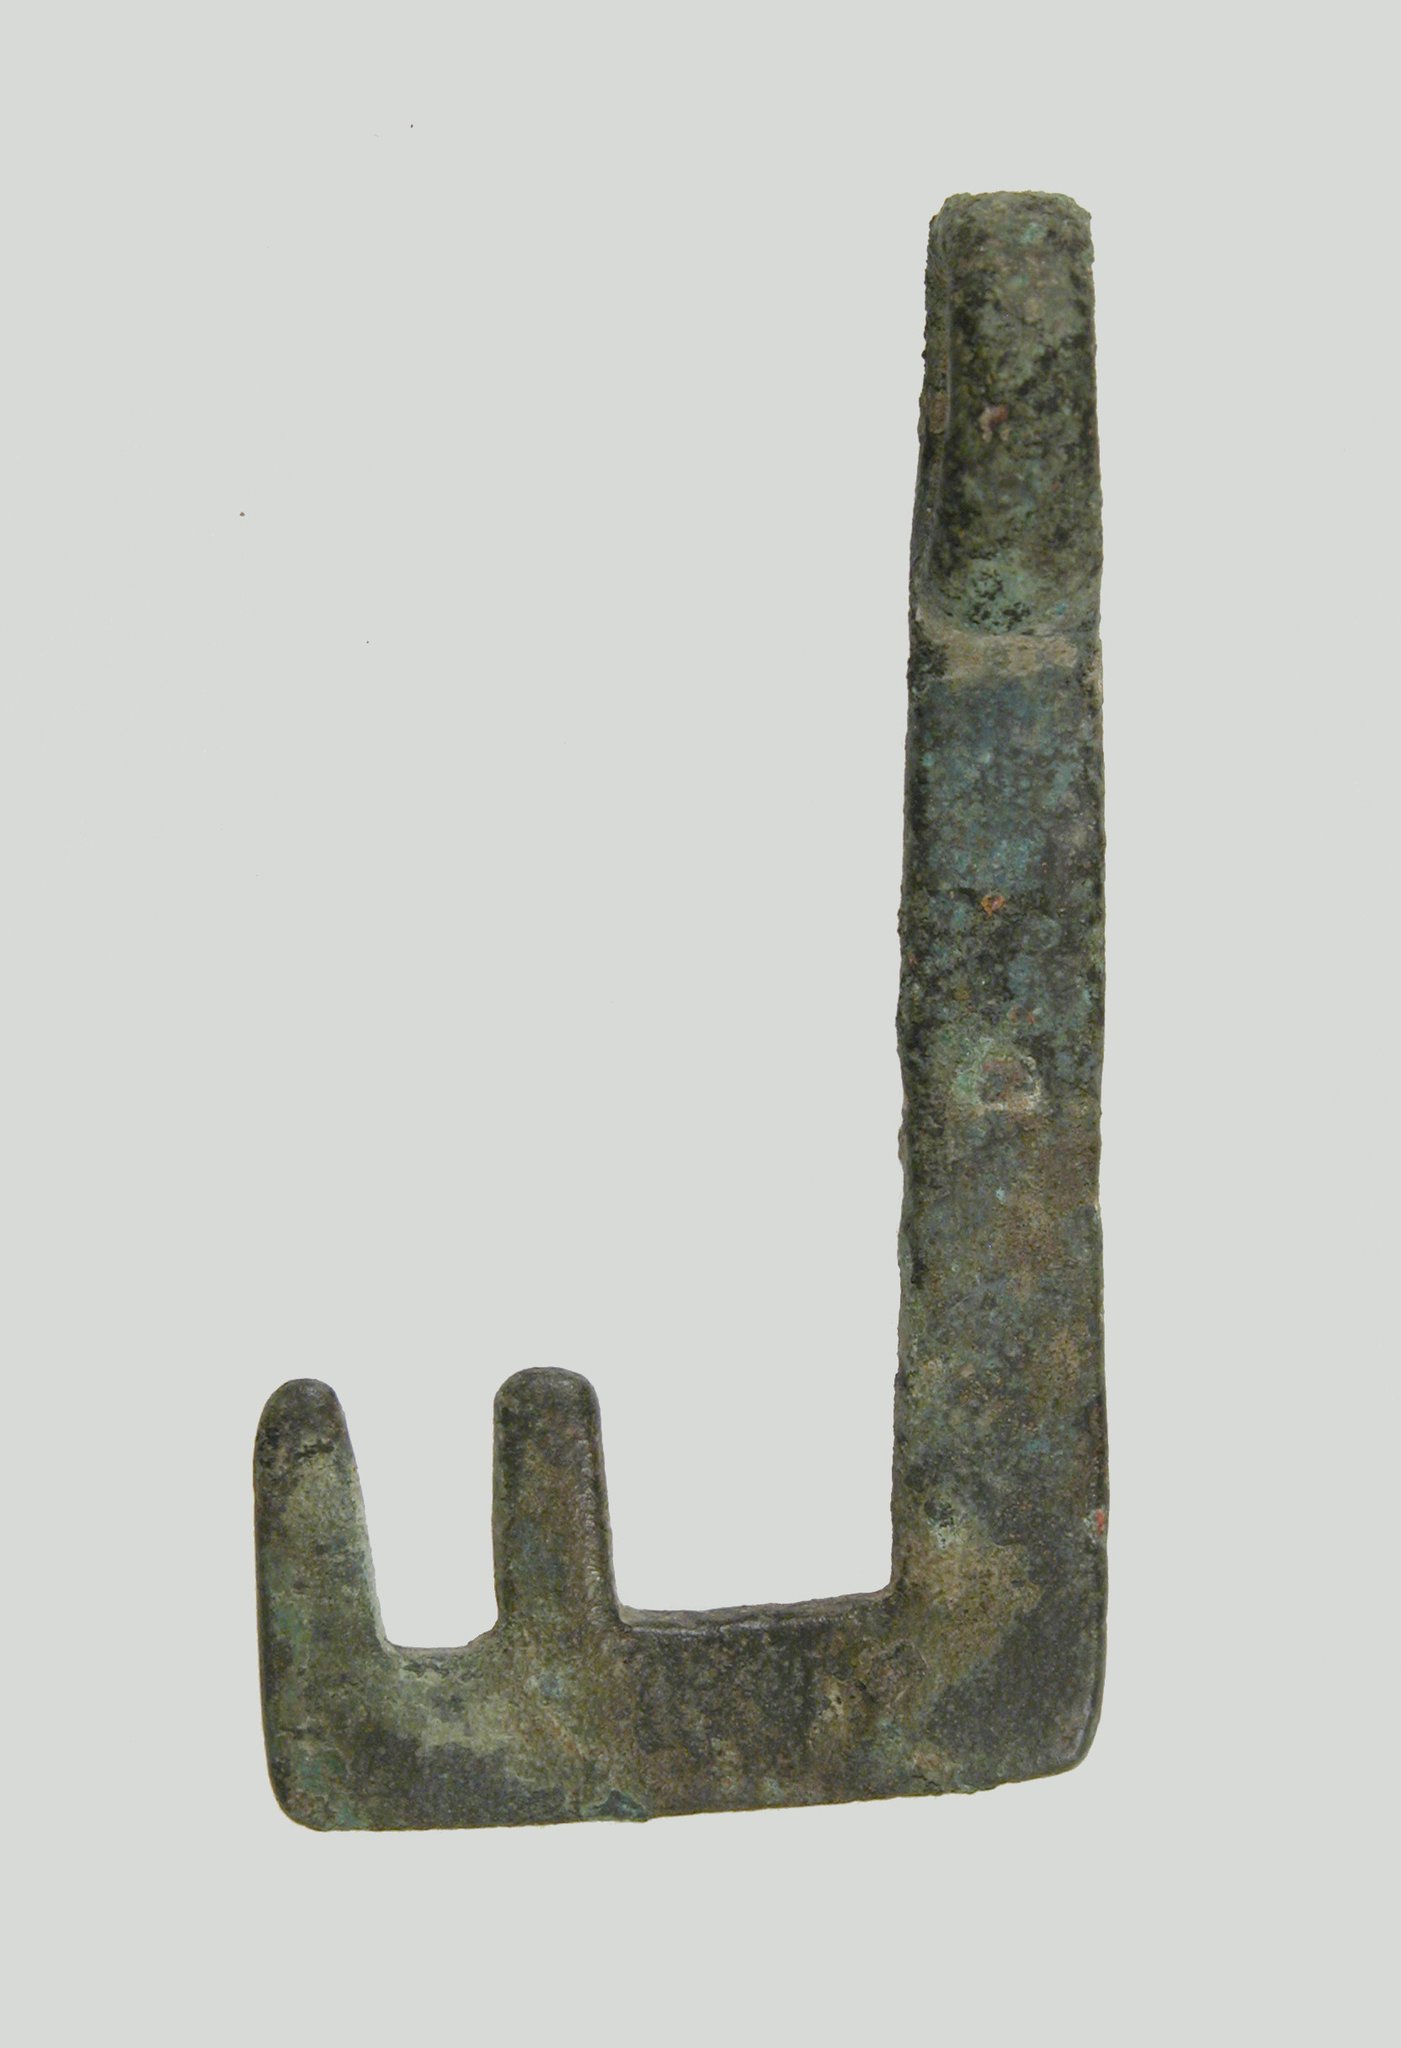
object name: key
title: L-Shaped Key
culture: roman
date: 501-700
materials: copper alloy